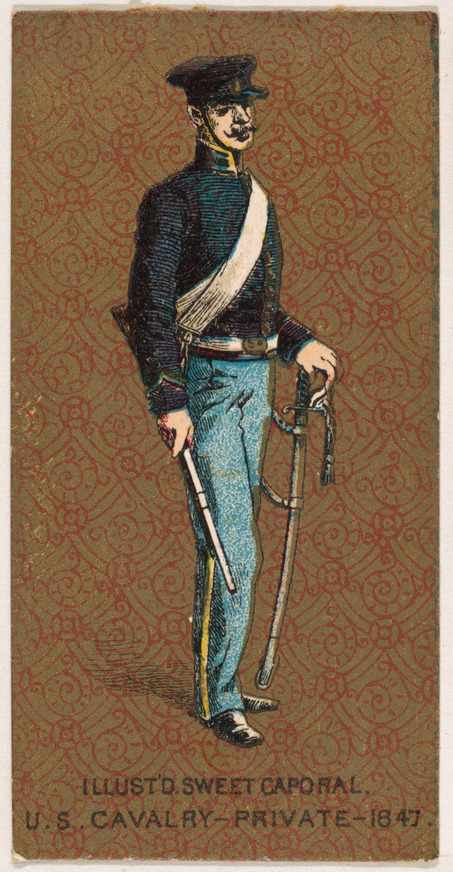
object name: print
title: Private, Cavalry, United States Army, 1847, from the Military Series (N224) issued by Kinney Tobacco Company to promote Sweet Caporal Cigarettes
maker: kinney brothers tobacco company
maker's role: publisher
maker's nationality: american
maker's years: 1869-2011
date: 1888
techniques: color lithograph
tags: soldiers,firearms,swords,men